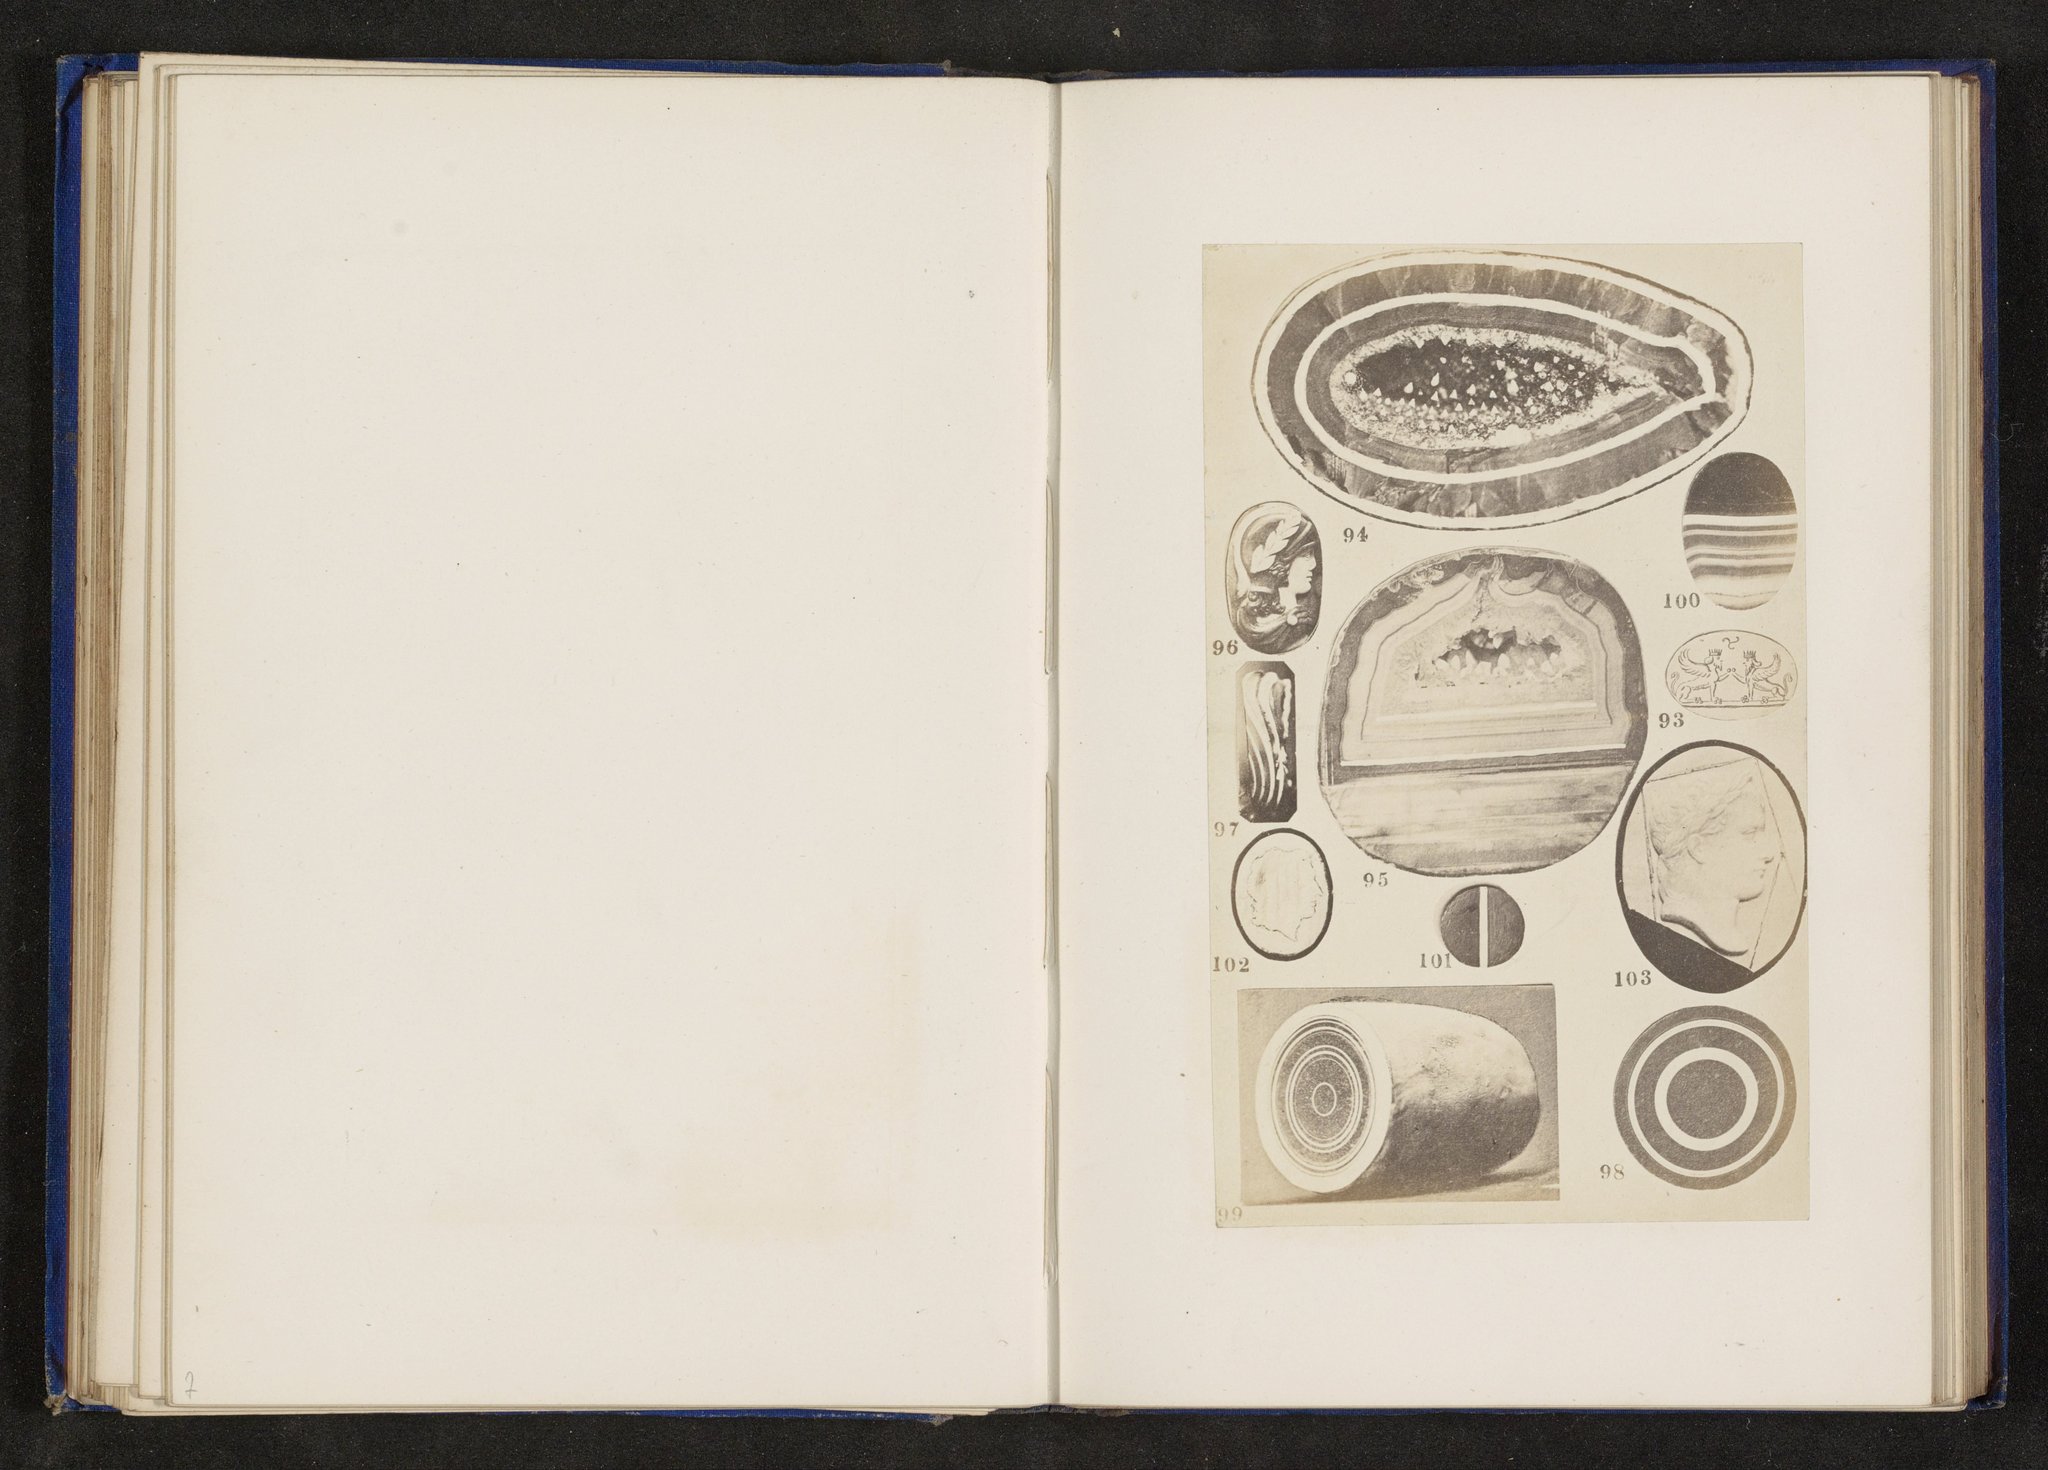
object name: photograph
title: Elf geoden en cameeën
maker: f. cole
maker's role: fotograaf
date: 1857-1867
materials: photographic support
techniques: albumen print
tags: carving ~ applied arts, gem, gemstone, sculpture (+ relief ~ sculpture)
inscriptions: number: ‘93 - 103’